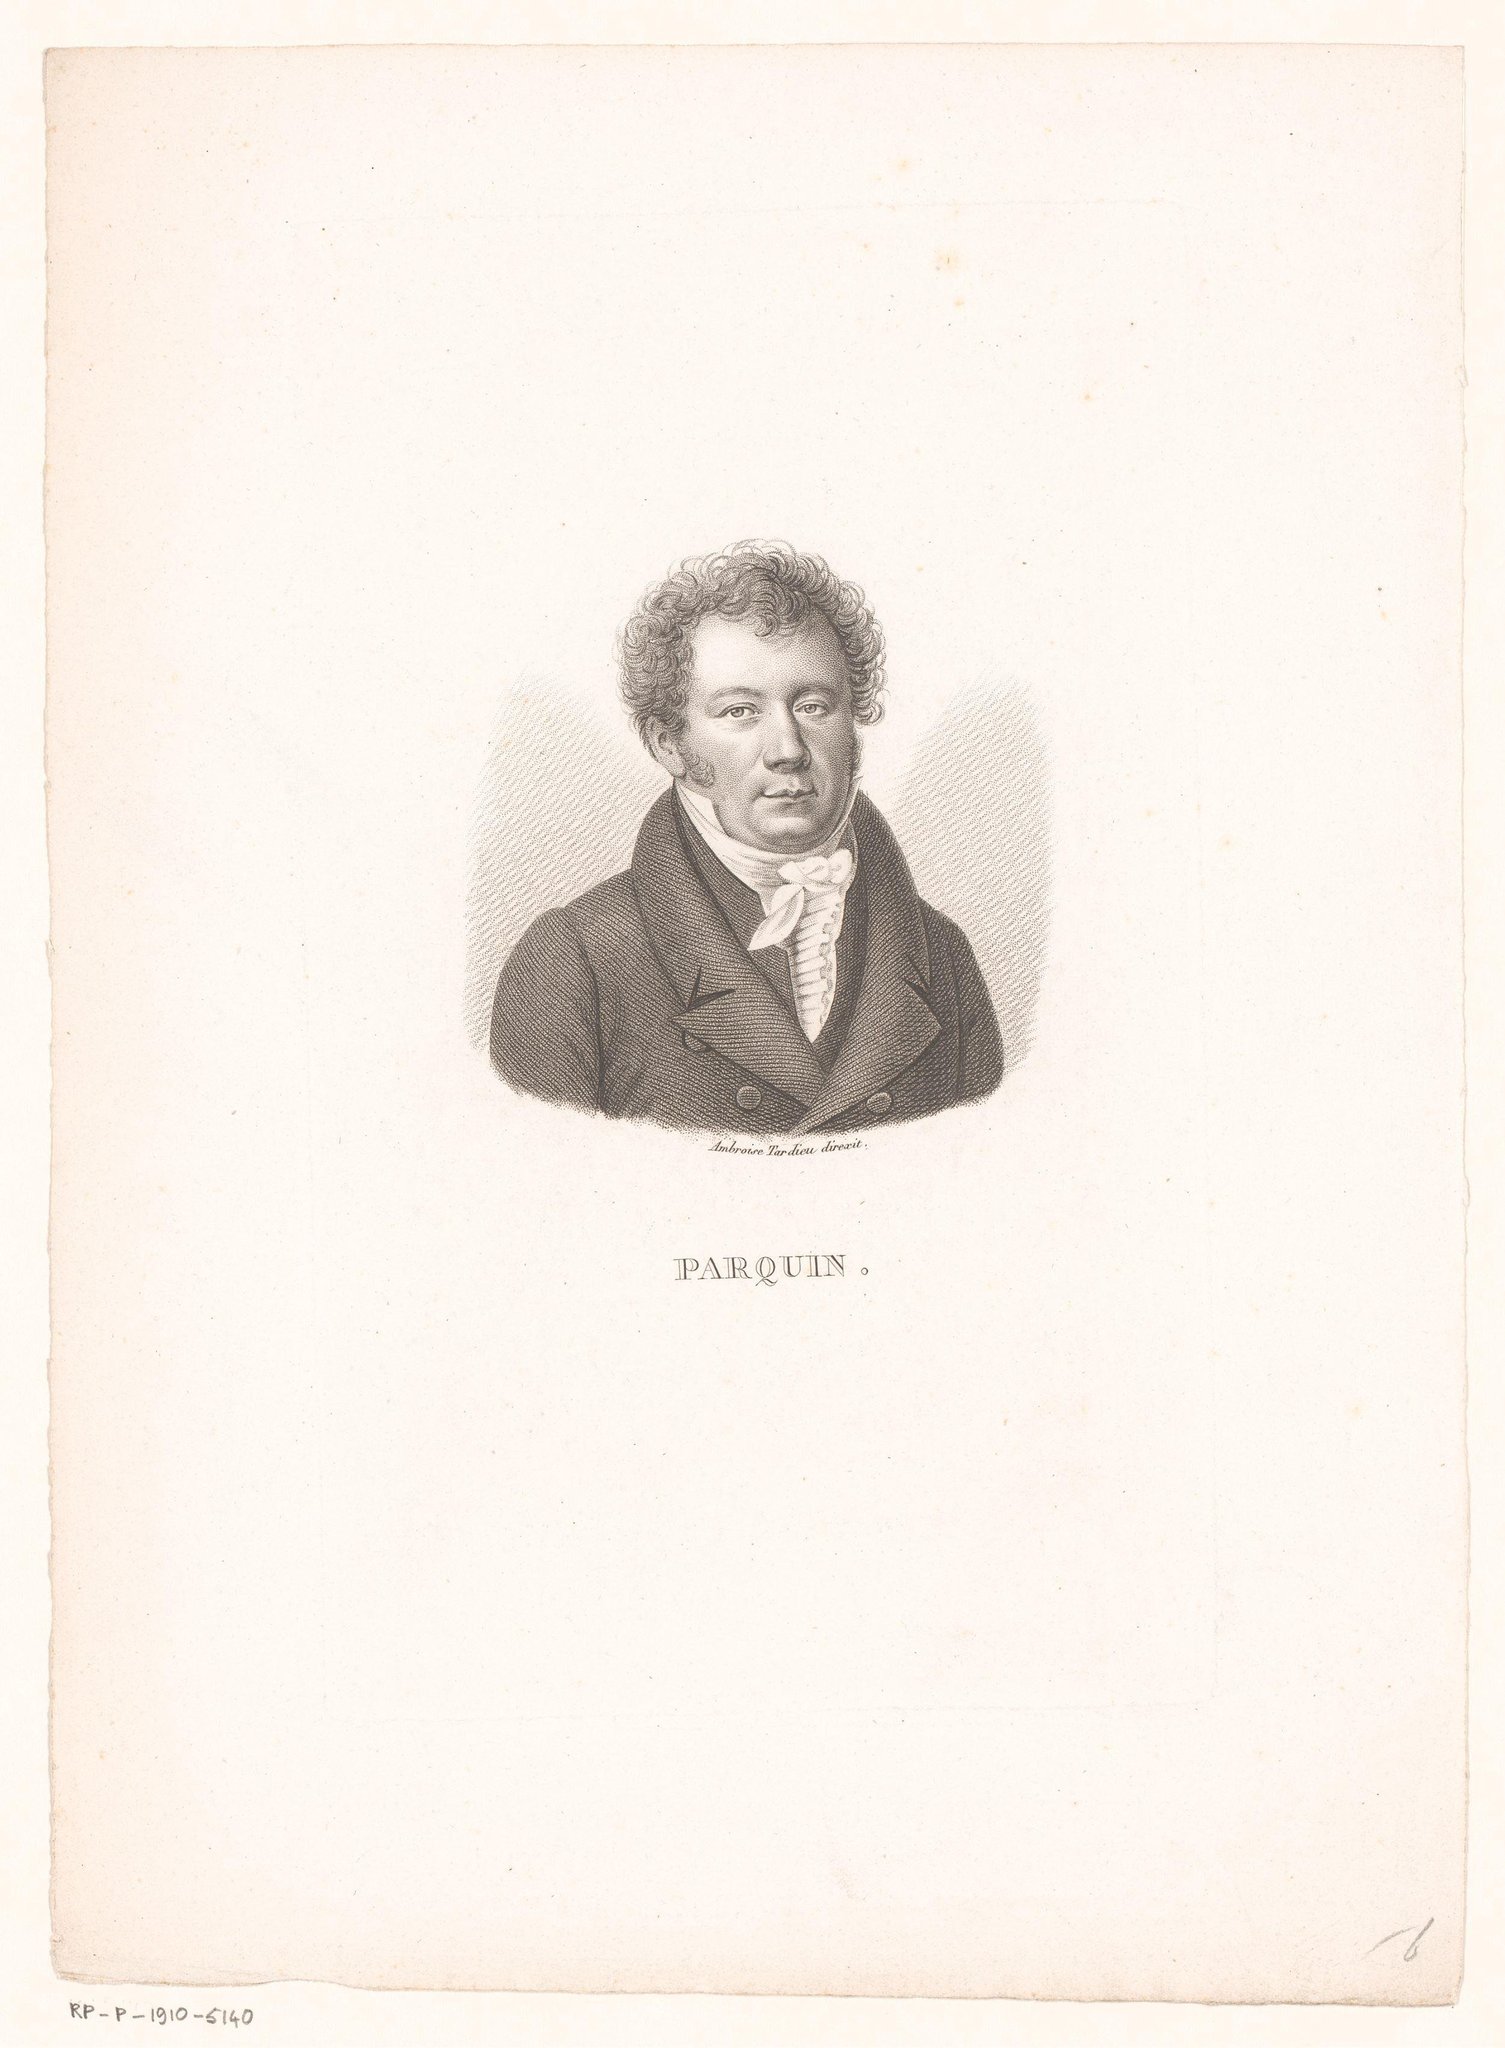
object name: print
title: Portret van Jean-Baptiste-Nicolas Parquin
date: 1821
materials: paper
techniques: engraving, roulette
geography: paris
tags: paris, historical persons, lawyer, attorney at law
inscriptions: collector's mark: Lugt 2228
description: Mogelijk prent uit: Barreau français. Collection des chefs-d'oeuvre de l'éloquence judiciaire en France. Parijs: Panckoucke, Charles Louis Fleury, ca. 1821.